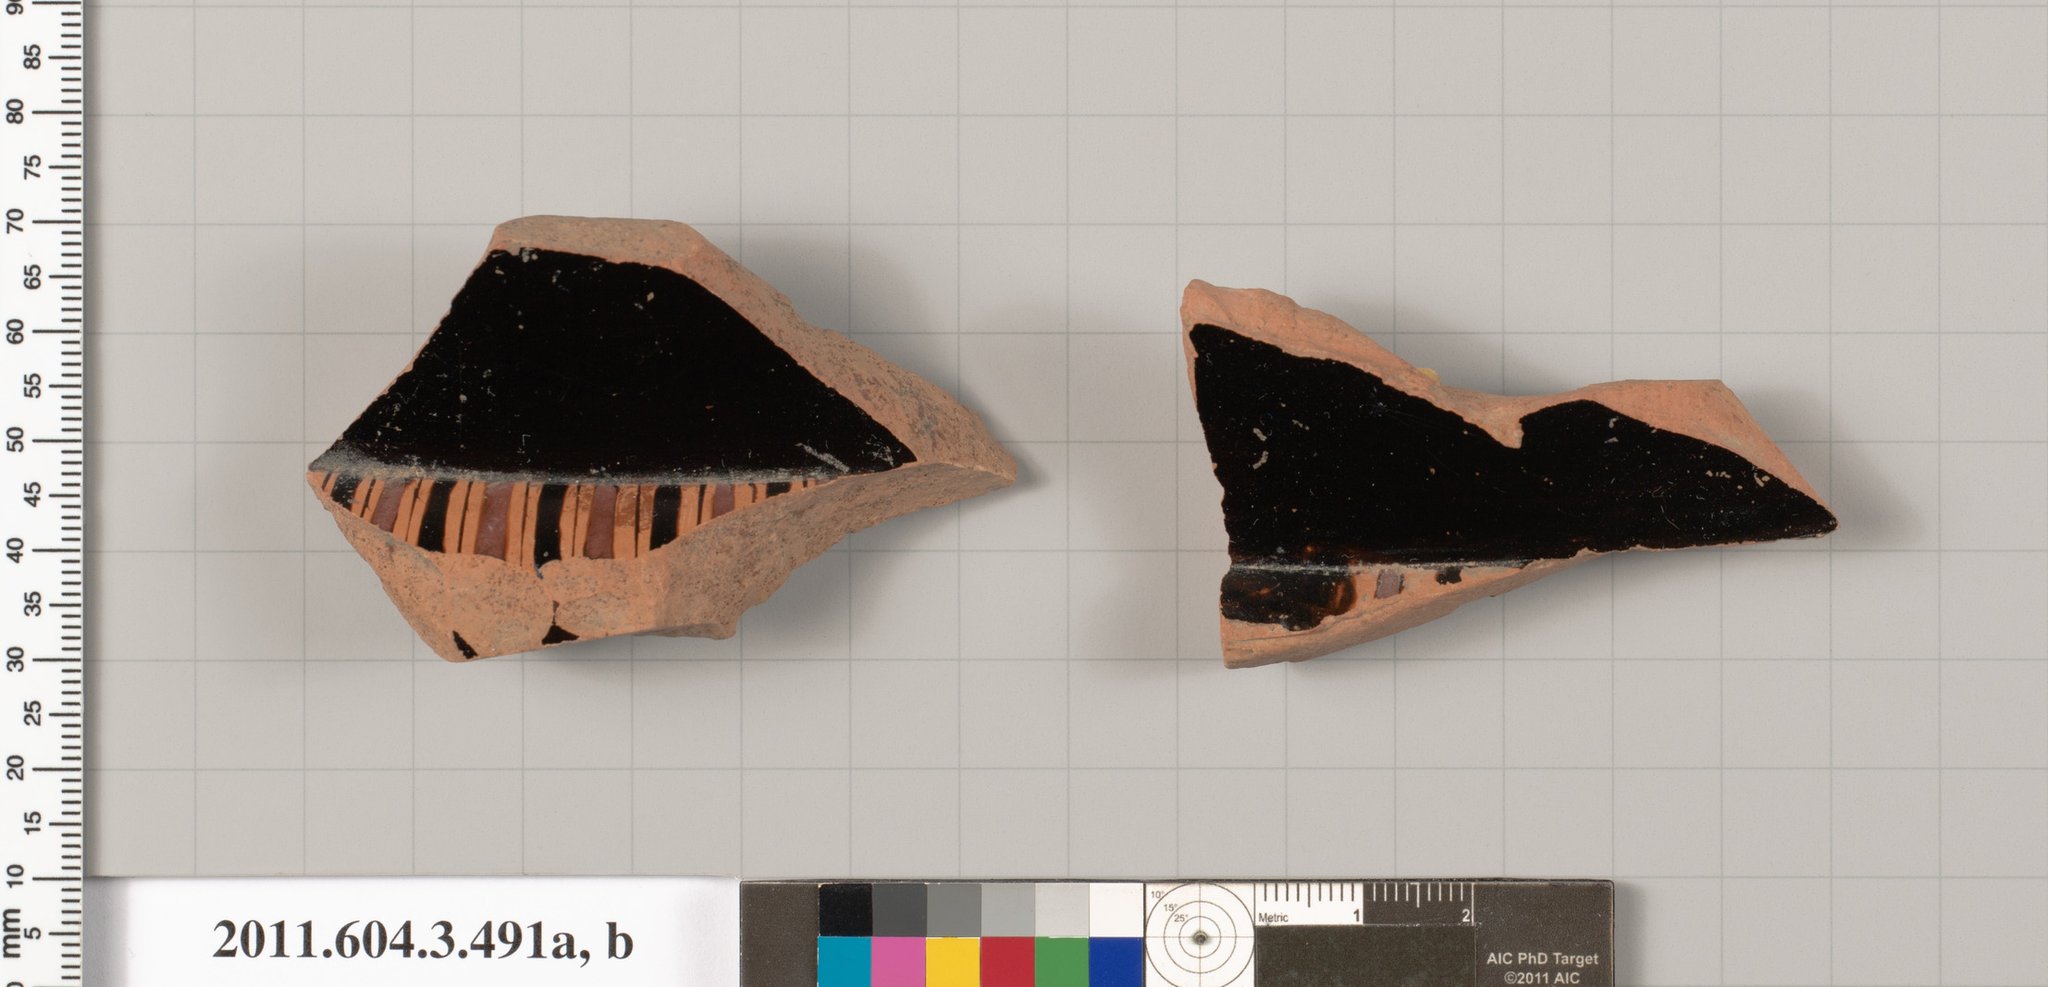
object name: column krater fragment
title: Terracotta fragments of a column-krater (bowl for mixing wine and water)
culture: greek, attic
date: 550-526 BCE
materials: terracotta